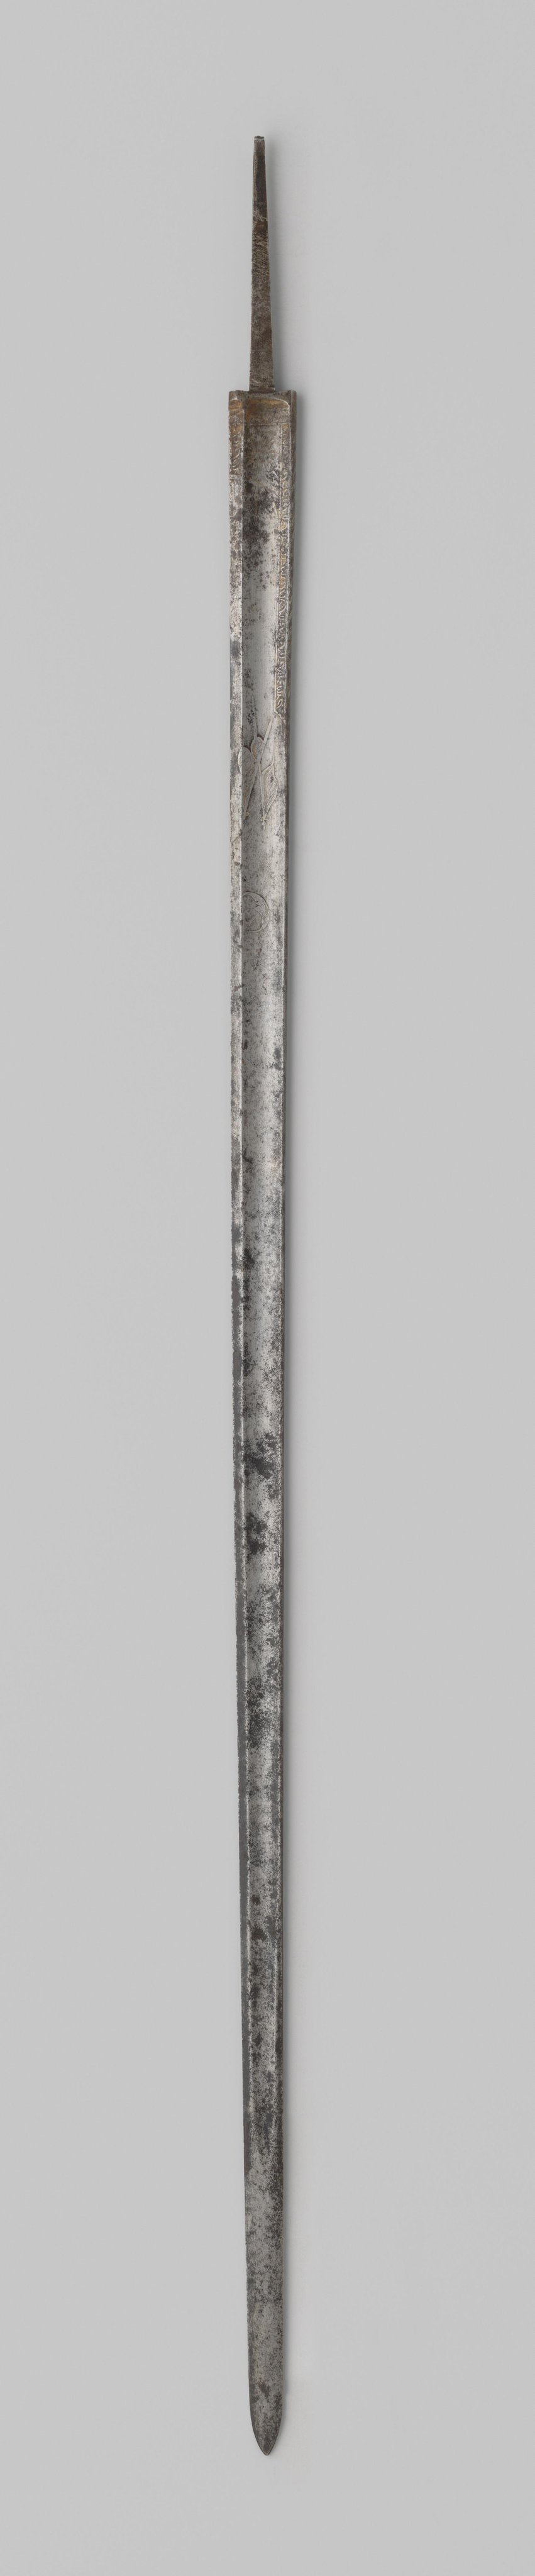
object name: sword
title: Degen, pareerstangen en stootplaat van geel koper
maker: Anonymous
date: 1750-1899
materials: iron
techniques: engraving, gilding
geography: solingen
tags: solingen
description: Degen van ijzer met brede bloedgeul. De kling is eensnijdend en gegraveerd met florare motieven, een halve maan en twee gekruiste vaandels. Aan weerzijden van de bloedgeul zijn diverse tekens ingegraveerd. Op het ricasso staat de naam Solingen en de initialen J.W.E.. Op de bolle klingrug zijn bladeren gegraveerd. Het gevest van de degen ontbreekt. De angel van de kling is aan het uiteinde licht gebogen.